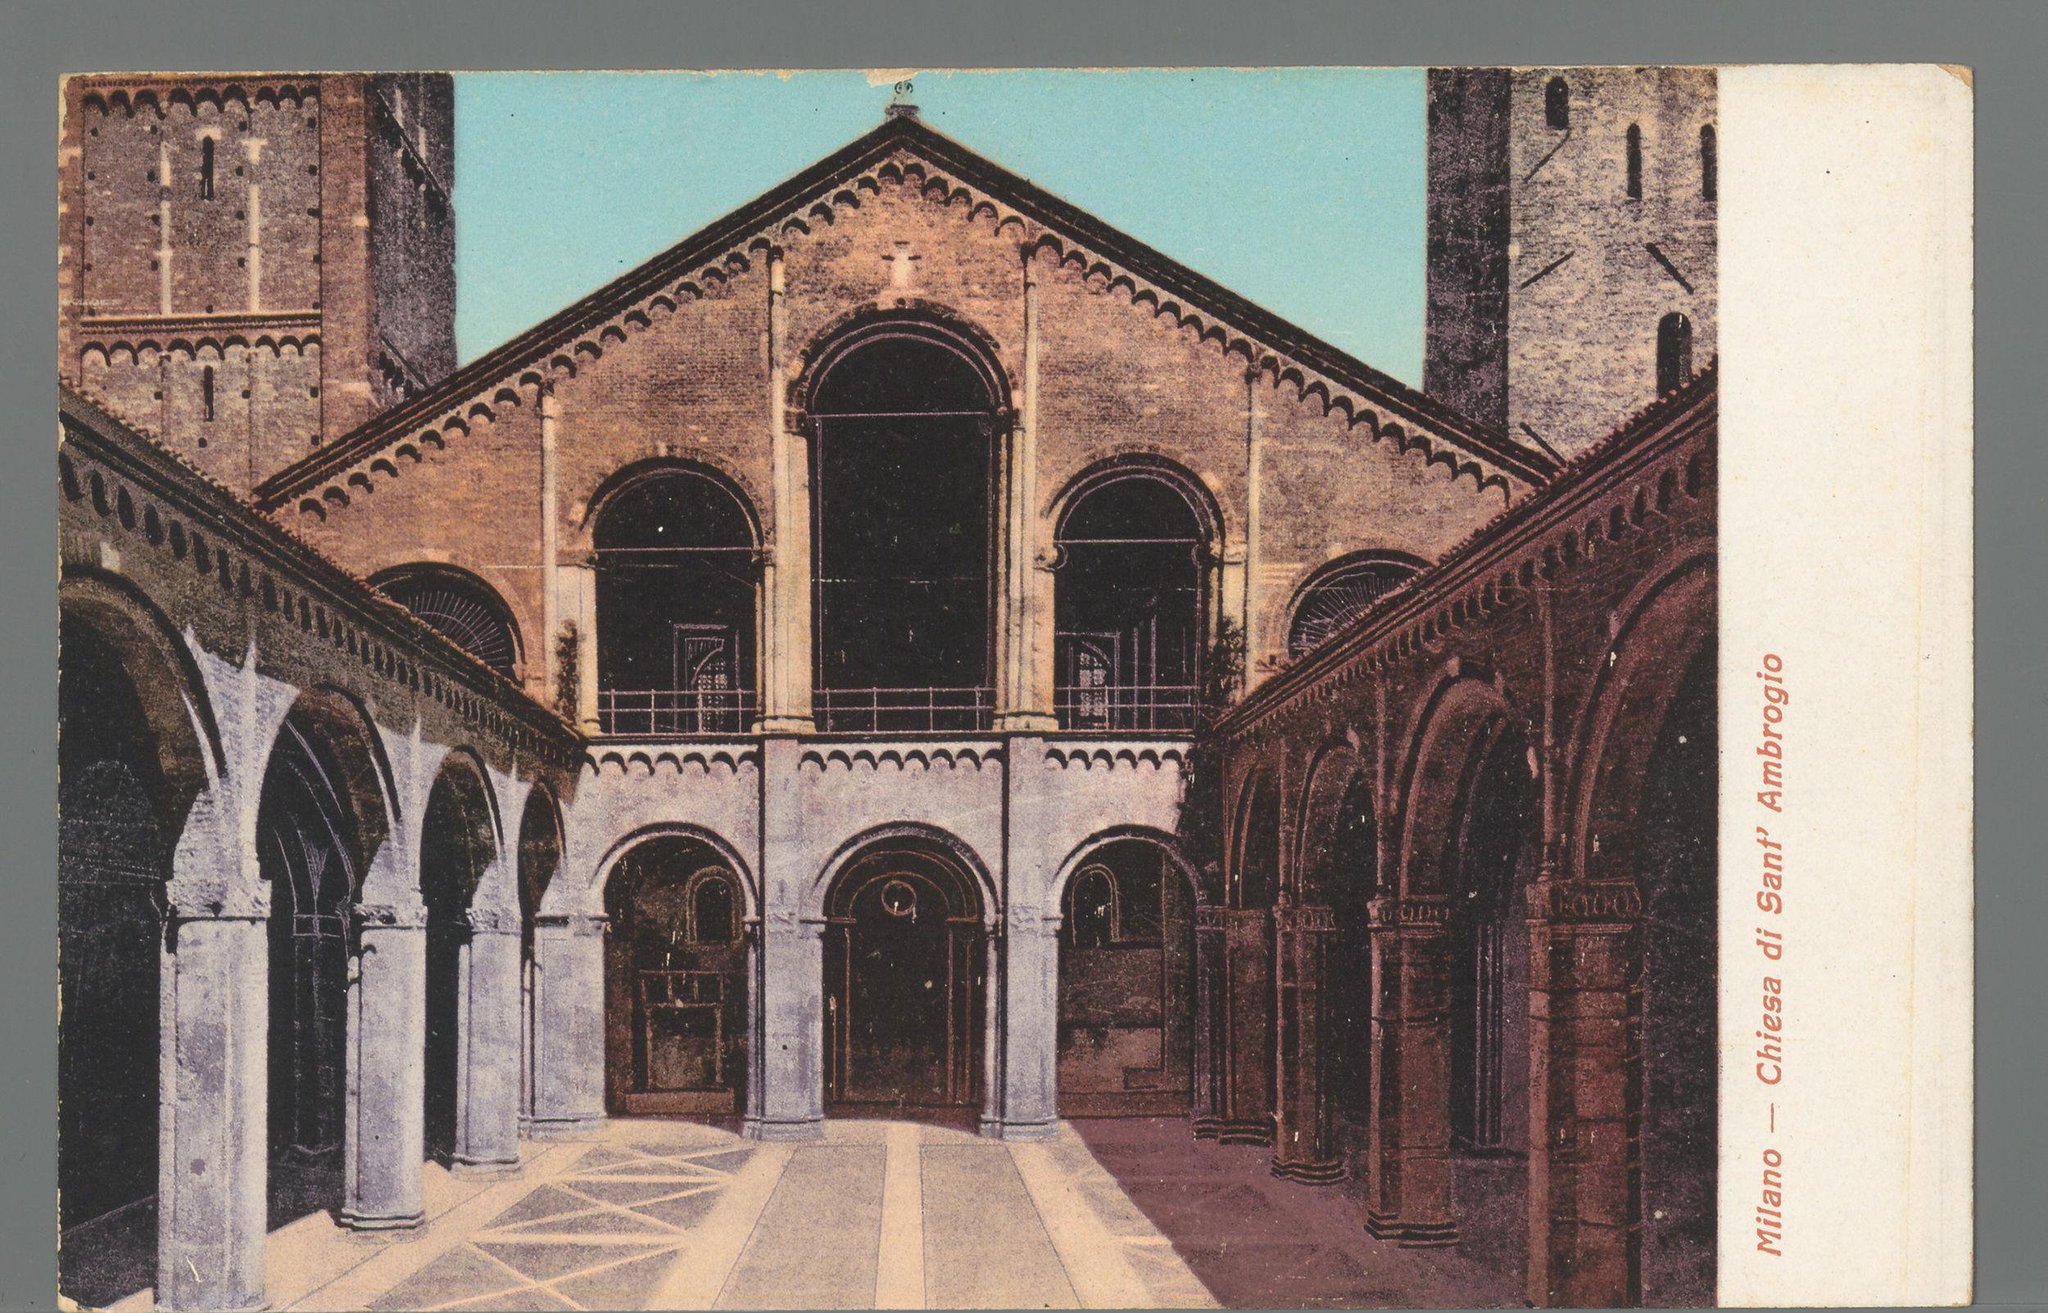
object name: photomechanical print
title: Milano. Chiesa di Sant'Ambrogio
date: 1906-1930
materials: cardboard, photographic process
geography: milan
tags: church (exterior), courtyard